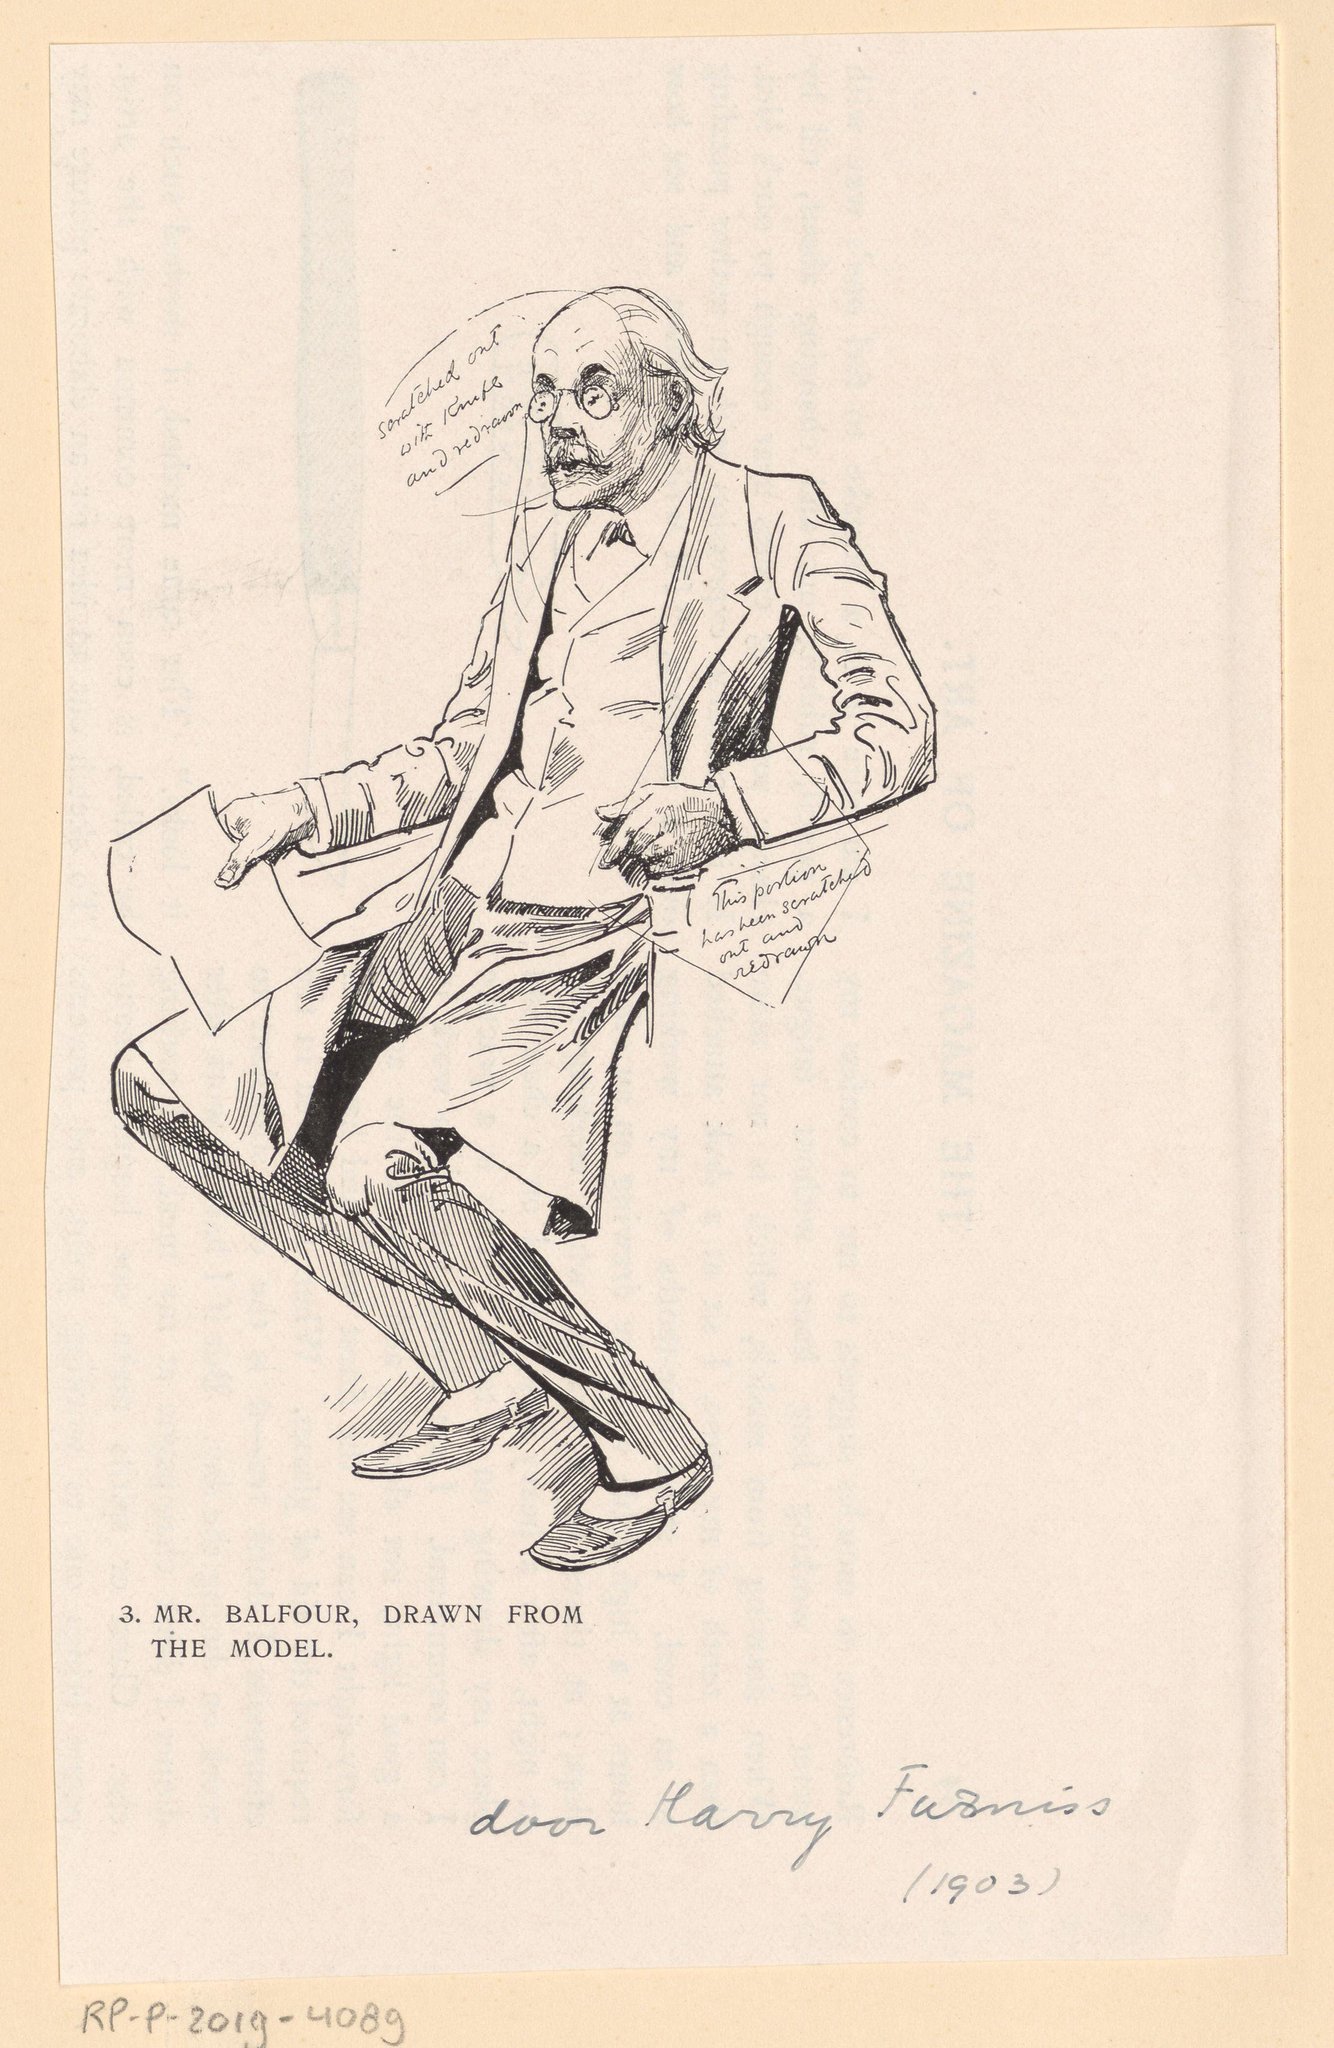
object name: photomechanical print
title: Portret van Arthus James Balfour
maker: Anonymous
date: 1903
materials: paper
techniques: letterpress printing, line block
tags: politician, historical persons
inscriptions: inscription: ‘door Harry Furniss (1903)’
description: Prent uit: The magazine of art. New series (1903), nr. 1, p. 33.